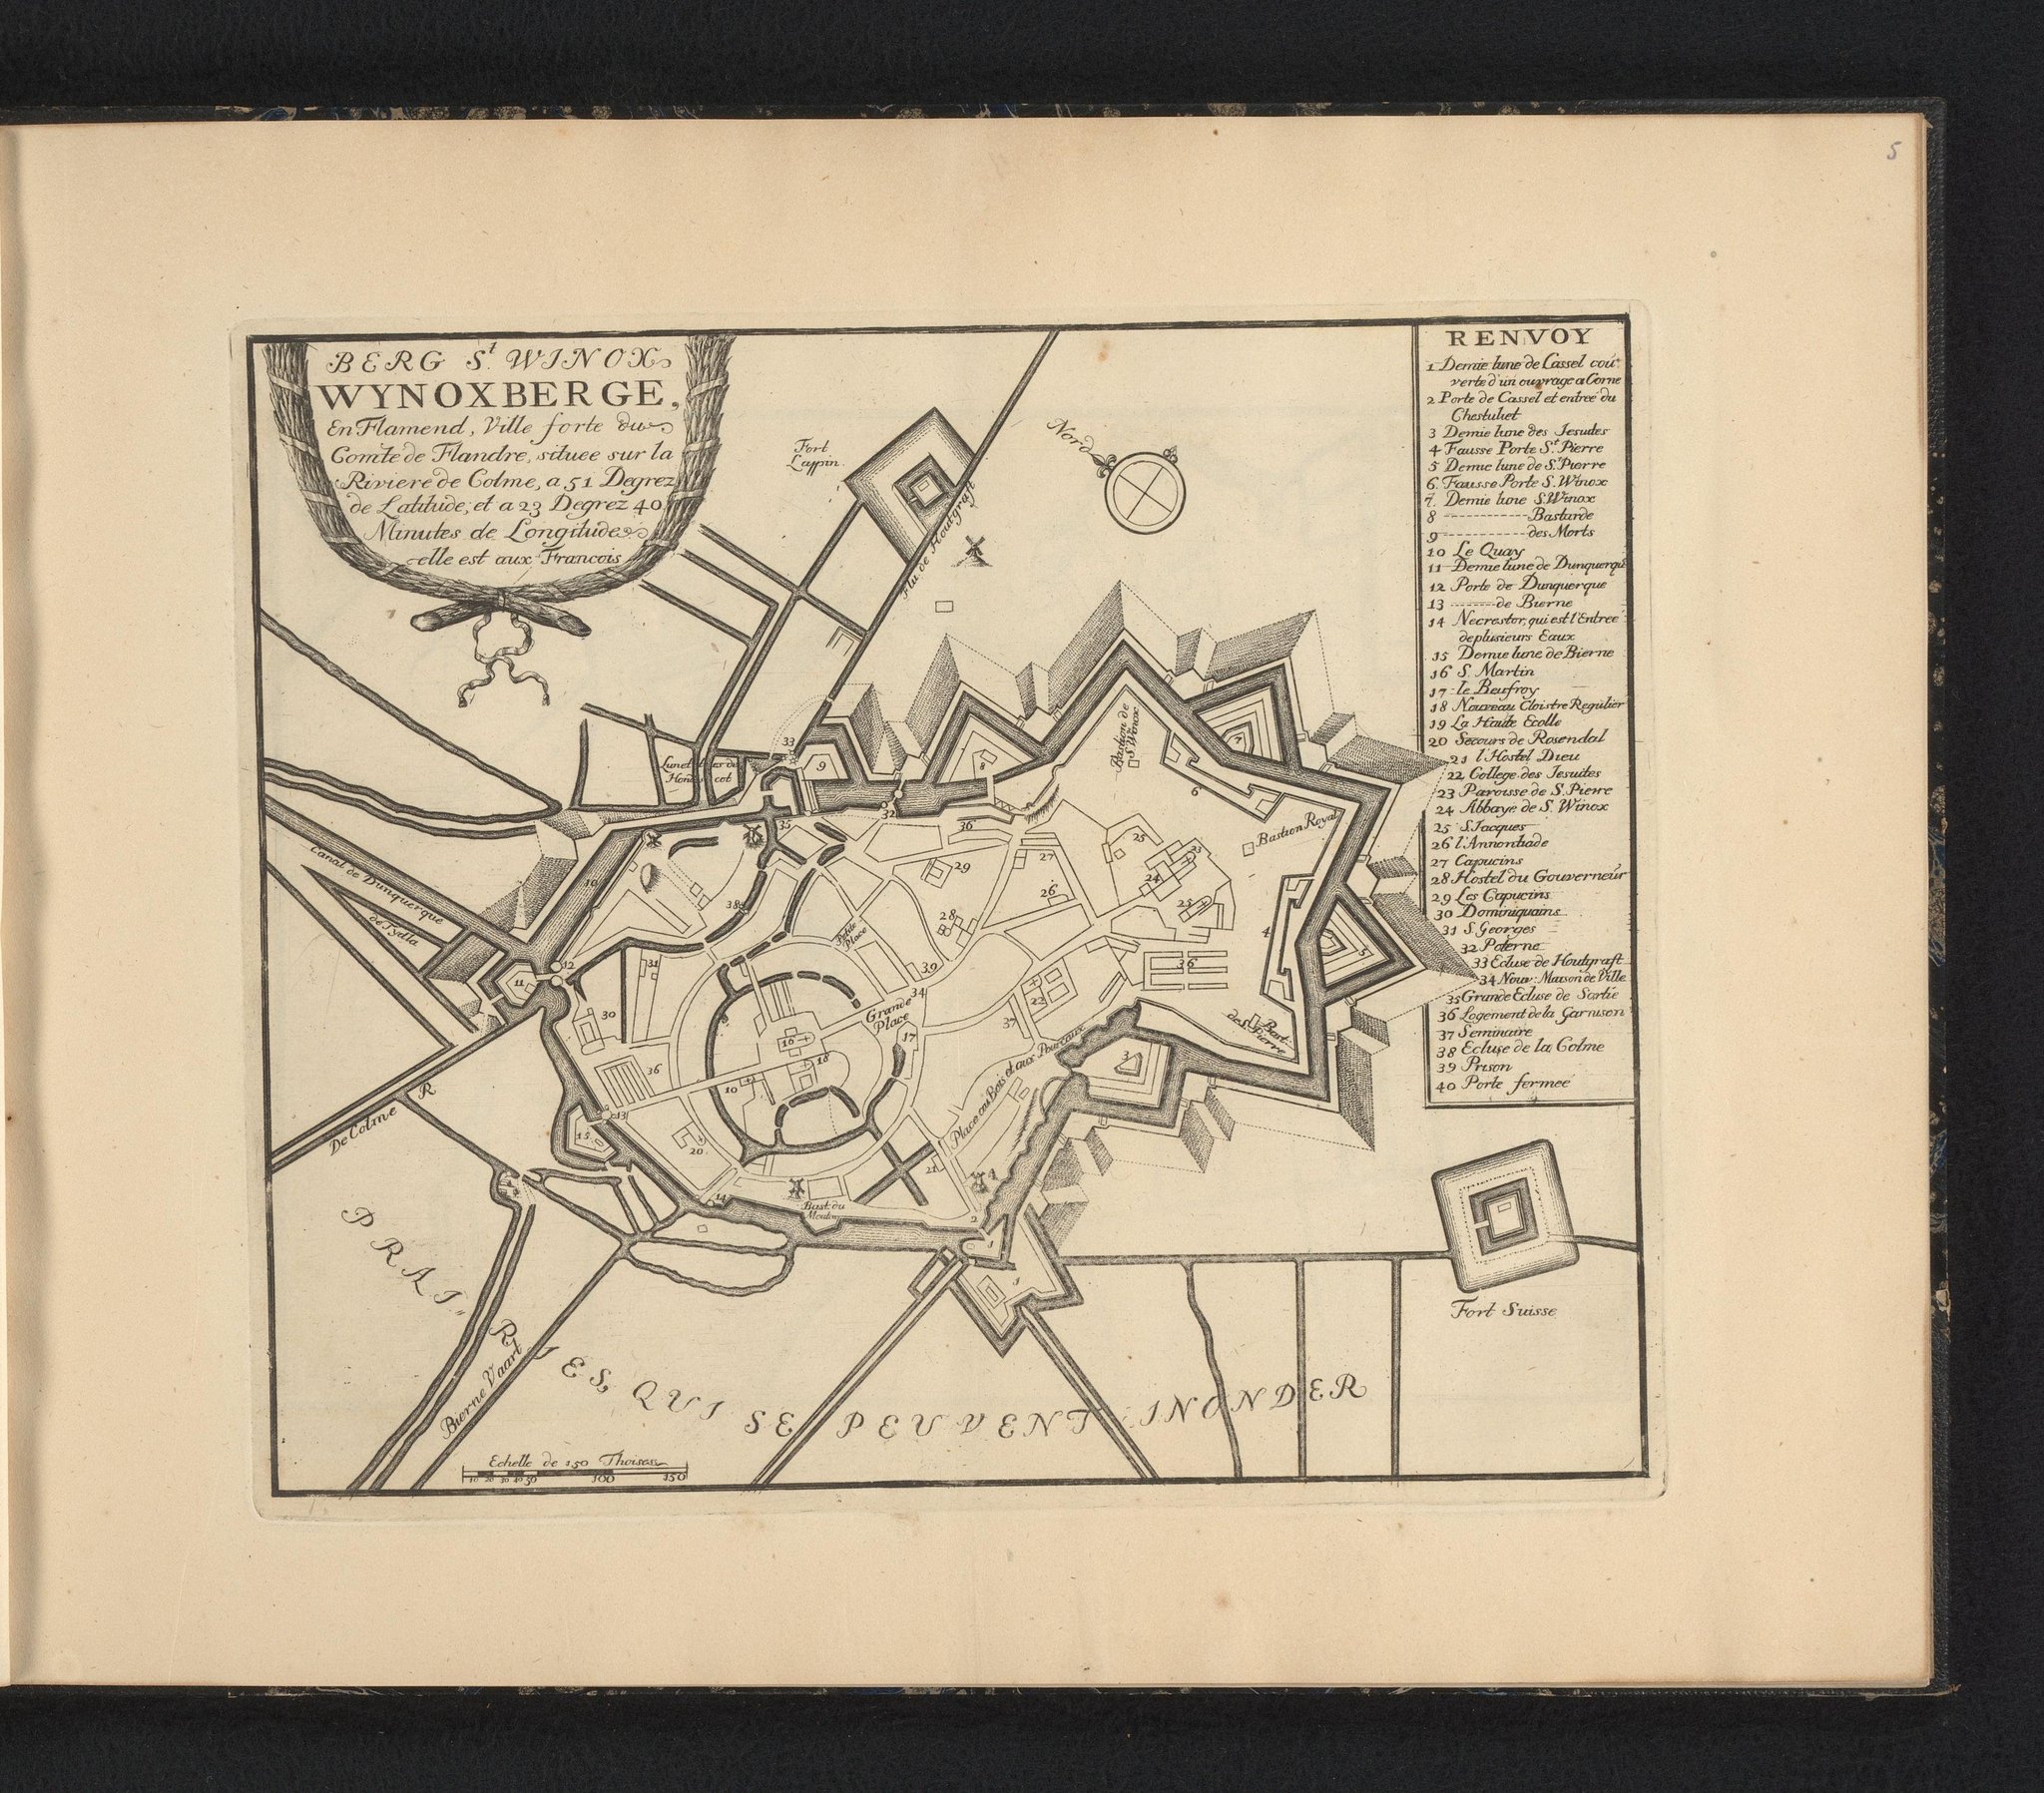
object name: print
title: Le theatre de la guerre, dans les Pays-Bas, ou representation des principales villes qui sont en Flandres, Hainaut, Brabant &c. Avec leurs fortifications (...) premier volume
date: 1693-1696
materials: paper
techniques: etching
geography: paris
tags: fortress, maps of cities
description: Plattegrond van de versterkingen om de Vlaamse (nu Franse) stad Sint-Winoksbergen (Bergues). Maakt deel uit van het eerste deel van het prentwerk: Le Theatre de la Guerre, dans les Pays-Bas, uitgegeven in 1696. Dit deel bevat 25 platen met plannen (afkomstig van Sébastien Le Prestre, Seigneur de Vauban) van vermaarde sterke steden en vestingen in de Negenjarige Oorlog in de Nederlanden. Titel en opschriften in het Frans.